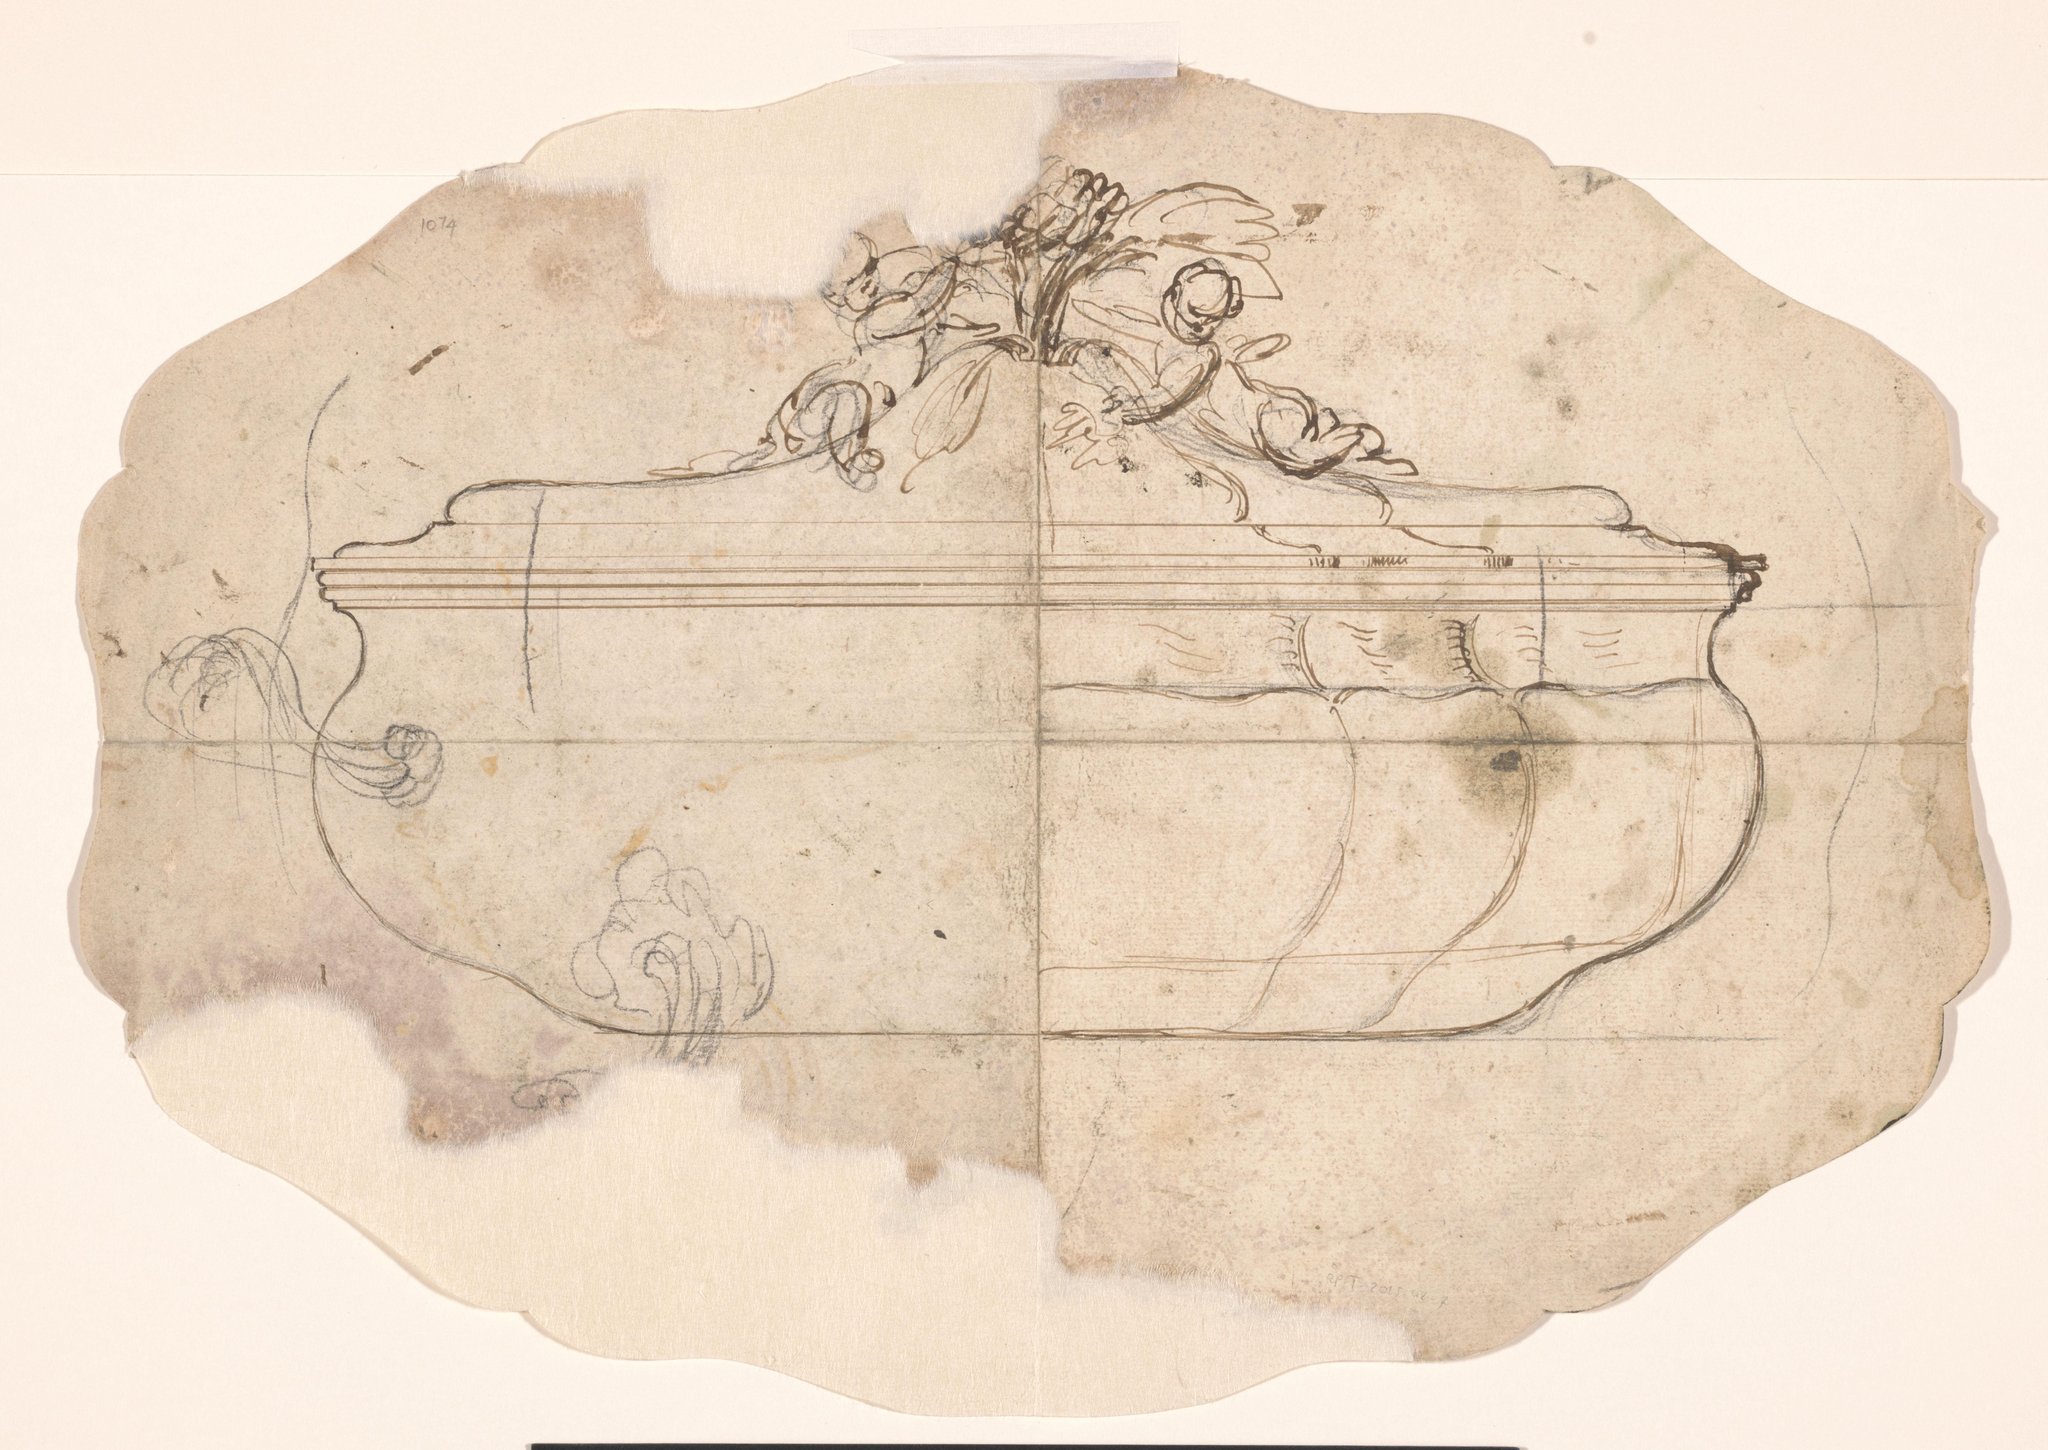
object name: design drawing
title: Ontwerp voor een terrine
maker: luigi valadier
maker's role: draughtsman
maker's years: 1726-1785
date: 1760-1770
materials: graphite, ink, paper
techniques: pen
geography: rome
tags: serving-dish, platter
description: Ontwerp voor een terrine bekroond door twee putti die een korenschoof flankeren, met op de rechterhelft aanduidingen van de bombering en op de linkerhelft schetsen van een oor en een poot. Verso een gecombineerd ontwerp voor een terrine en een pot à oille, met op de rechterhelft schetsen van een oor en een poot, met een doorsnee van de terrine en een binnenrand van de onderschotel van de omtrekvorm in grafiet en pen en bruine inkt.